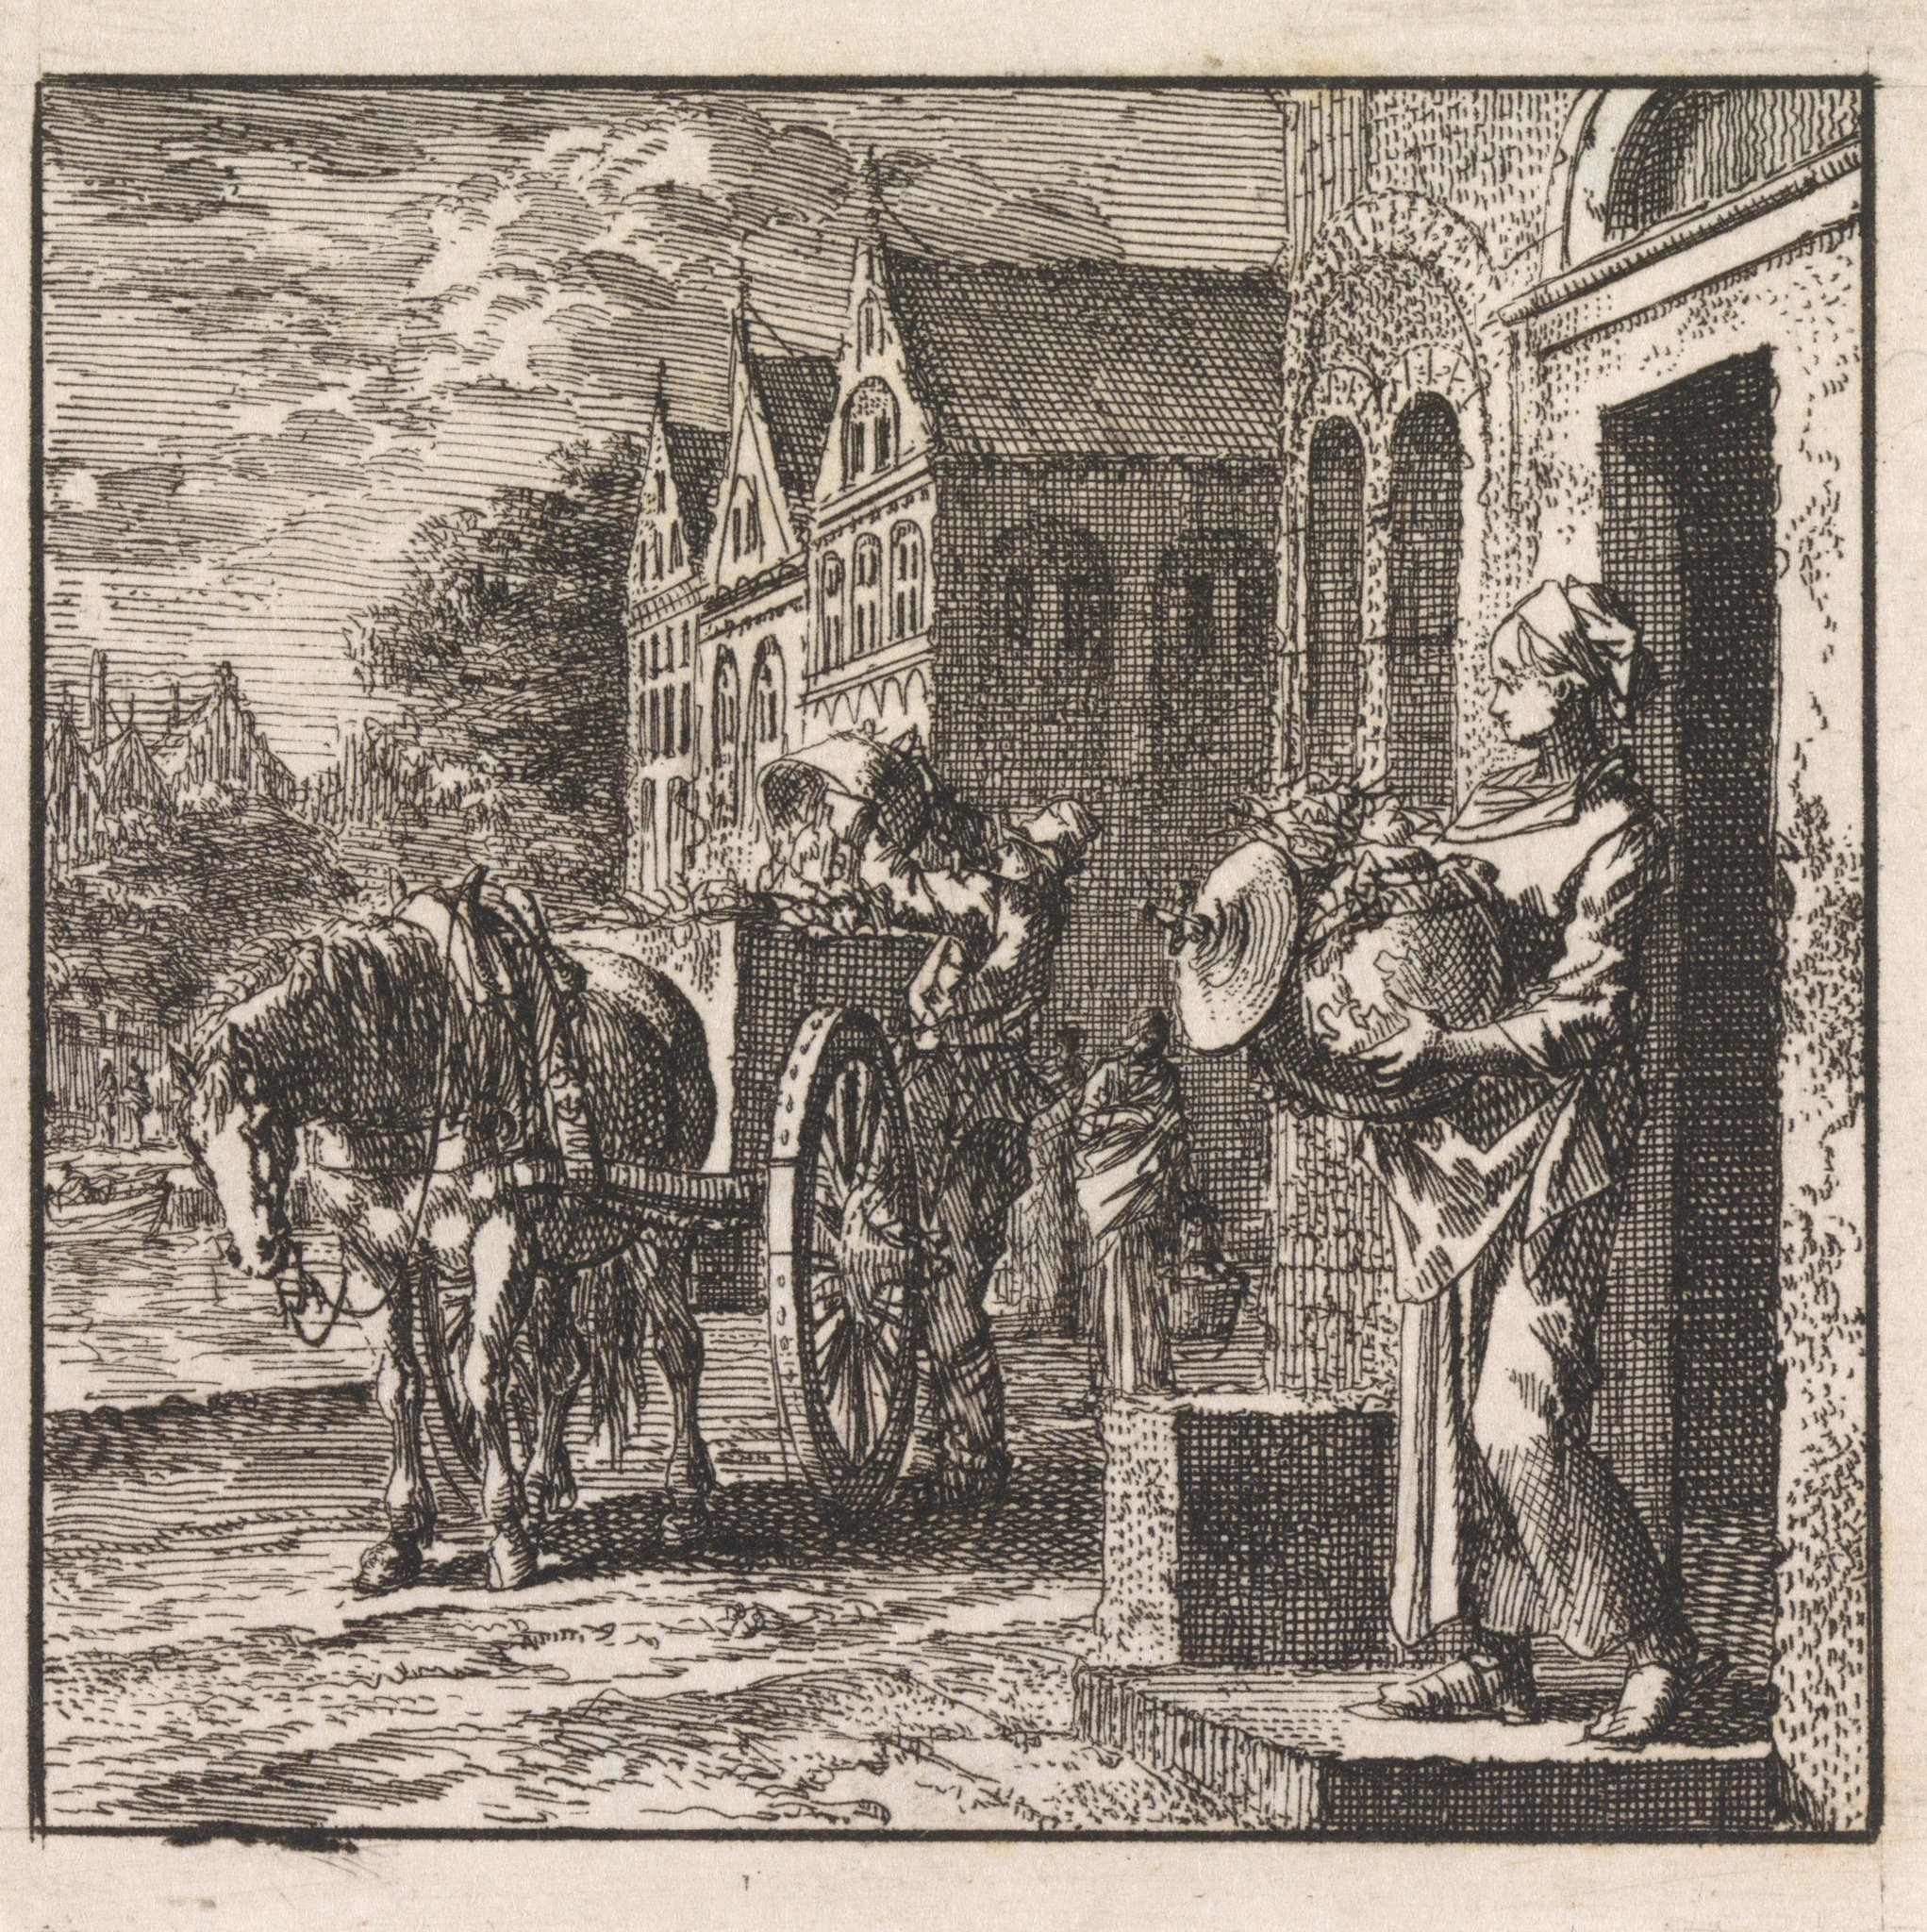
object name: print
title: Het Vat van Oneer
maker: jan luyken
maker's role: draughtsman, print maker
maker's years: 1649-1712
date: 1710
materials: paper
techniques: etching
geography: amsterdam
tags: earth, world as celestial body, garbage collecting lorry, garbage truck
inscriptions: collector's mark: Lugt 2228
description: Proefdruk voor illustratie uit: Luyken, Jan. De onwaardige wereld, vertoond in vyftig zinnebeelden, met godlyke spreuken en stichtelyke verzen. Amsterdam: Pieter Arentsz. II (wed.) en Cornelis van der Sys, 1710, p. 164.